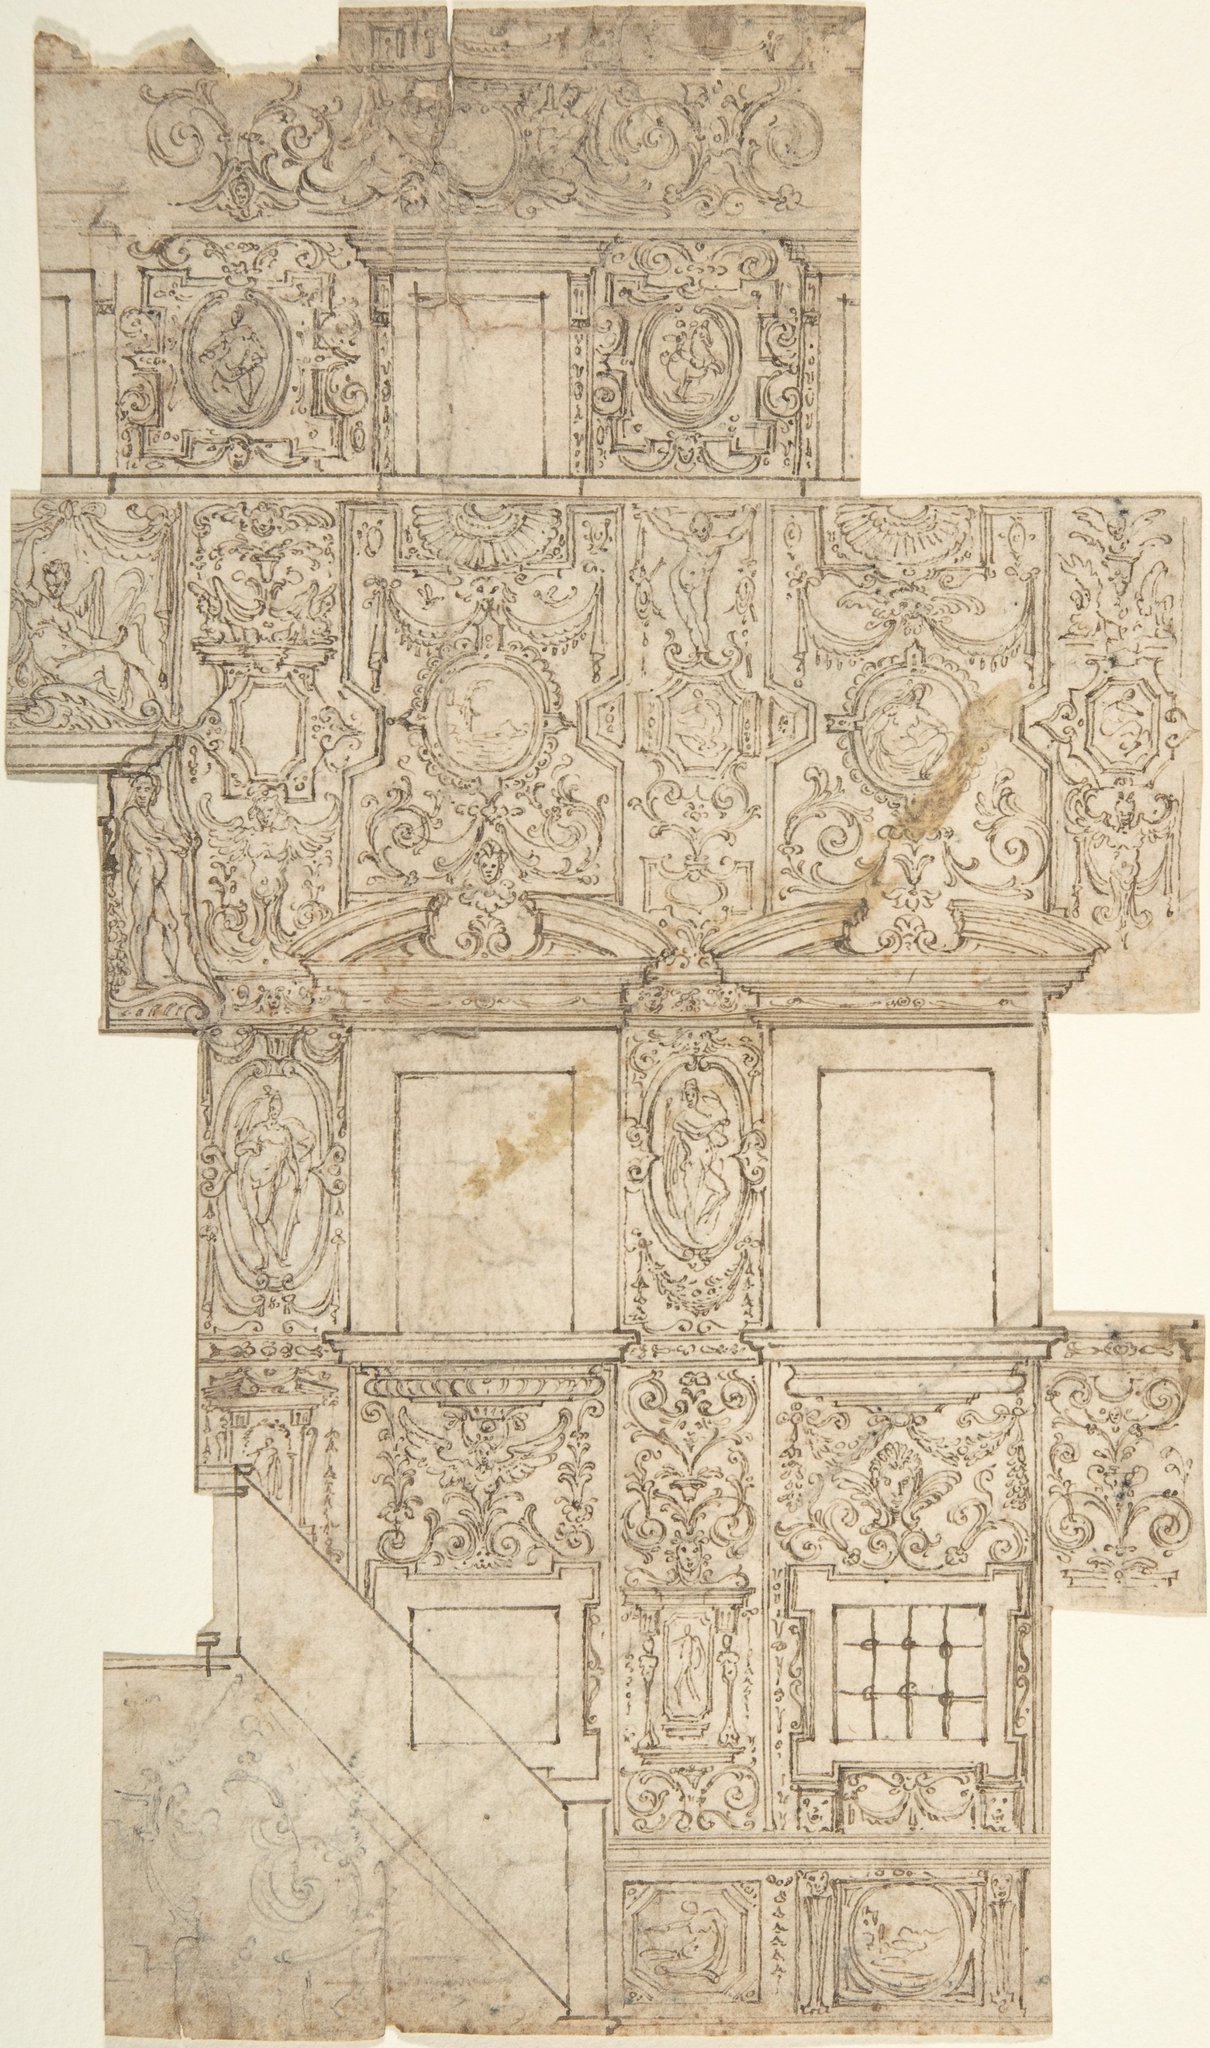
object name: drawing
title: Design for a Façade with Sgraffito Decorations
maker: anonymous, italian, 16th century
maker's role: artist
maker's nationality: italian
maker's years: 1500-1600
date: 1501-1600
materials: chalk, ink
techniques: pen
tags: architecture,ornament